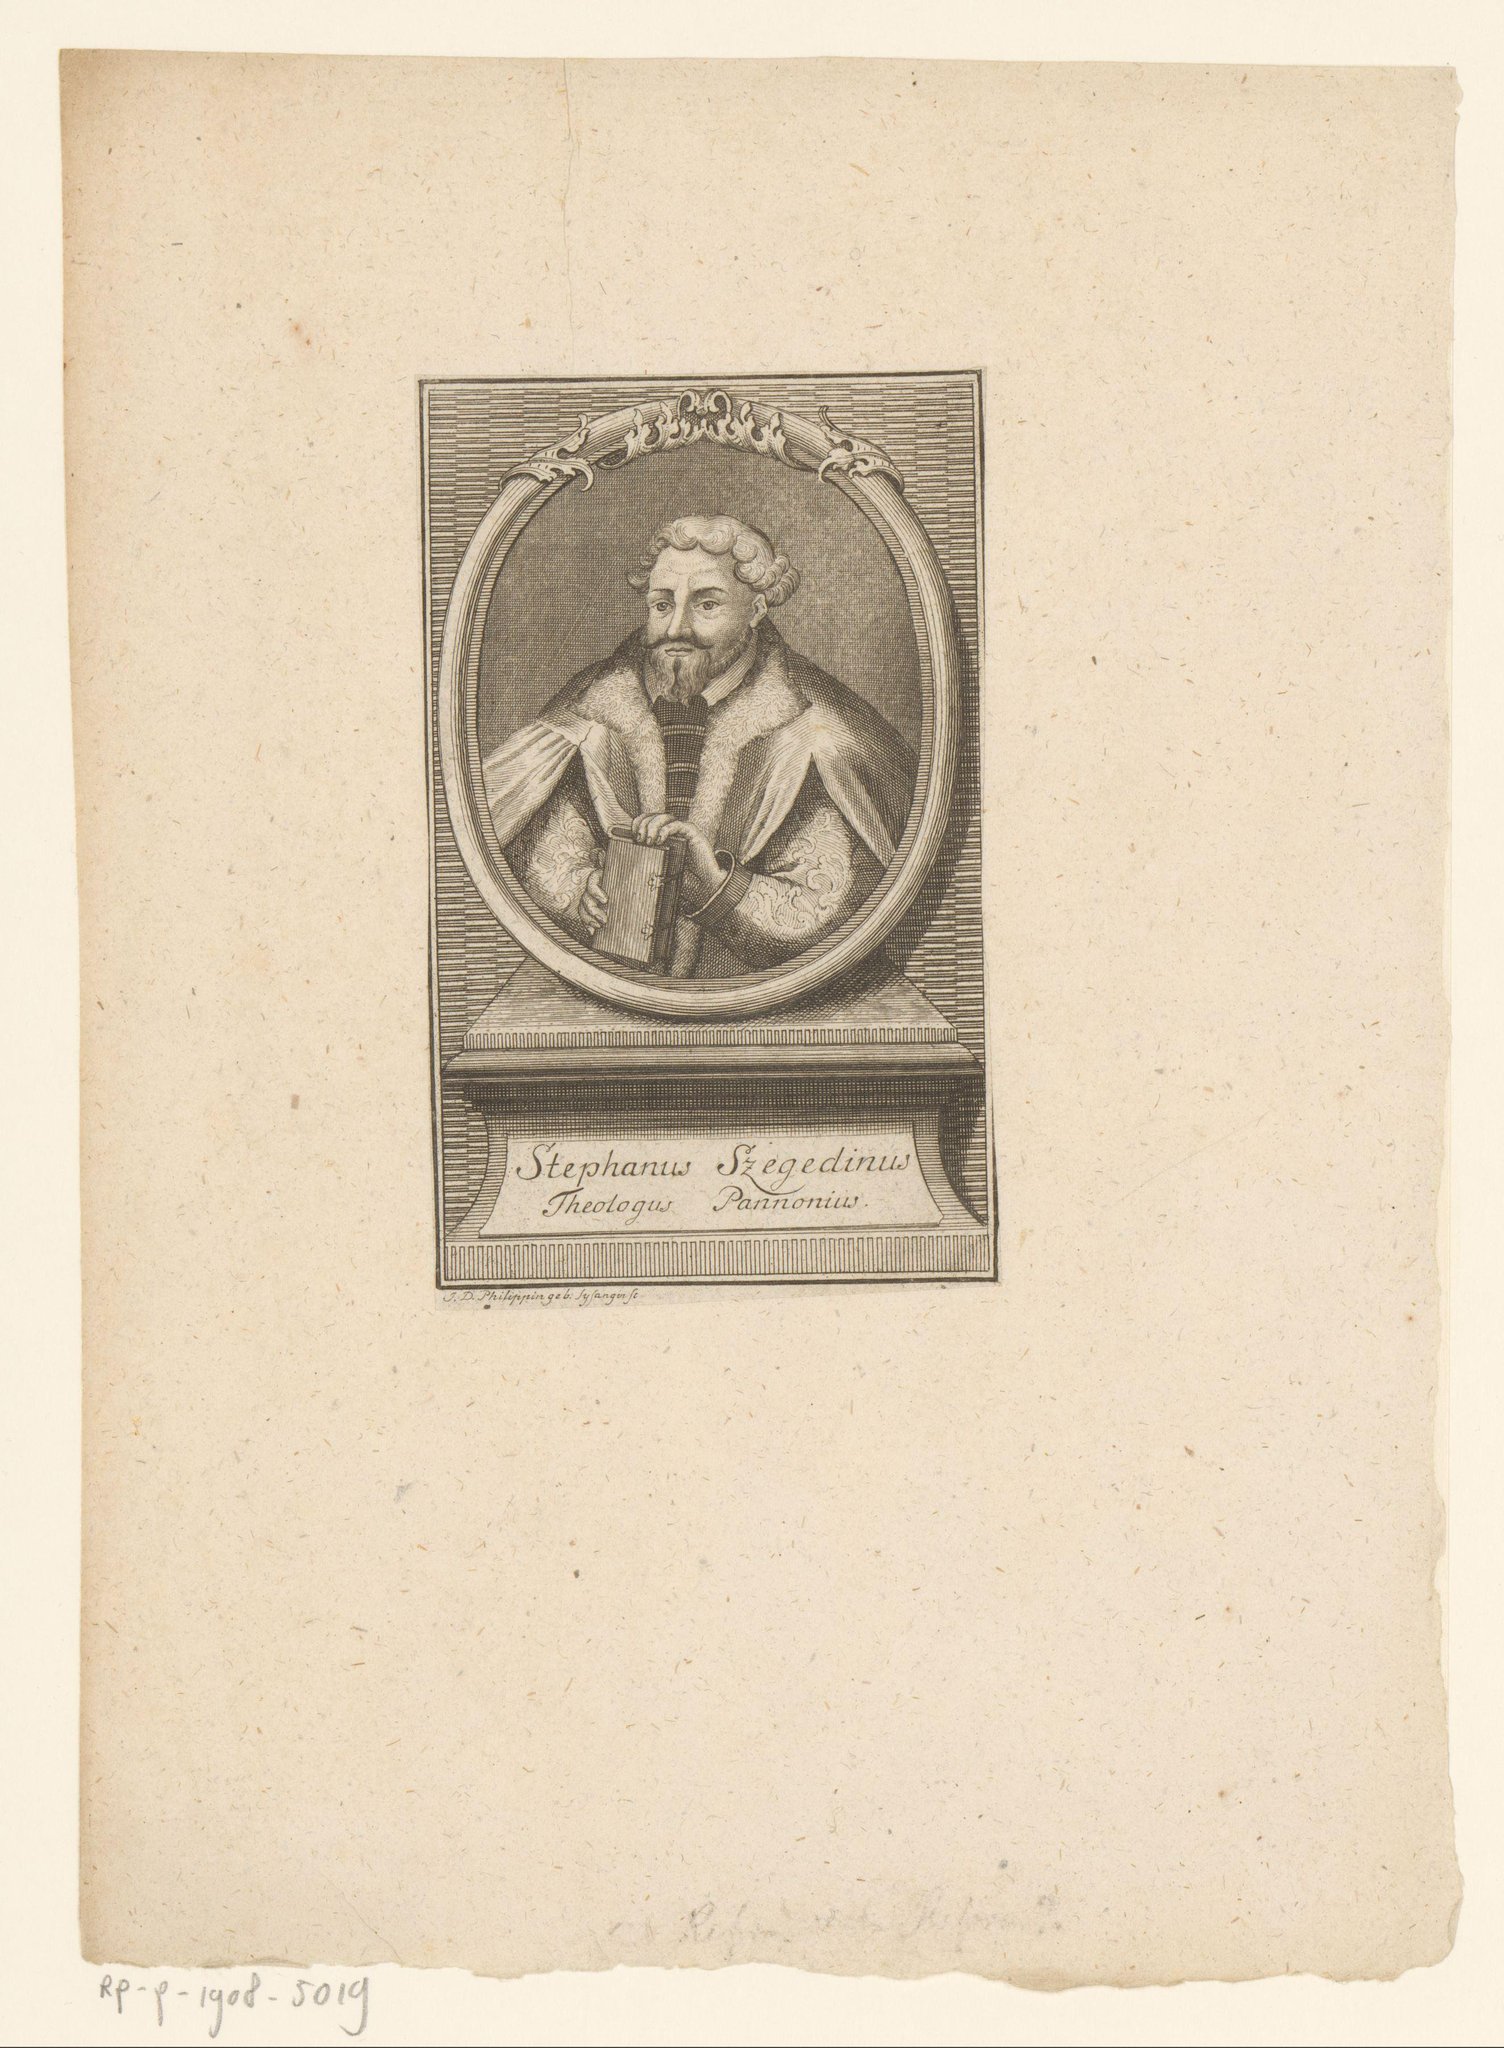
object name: print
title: Portret van Stephanus Szegedinus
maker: johanna dorothea sysang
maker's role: print maker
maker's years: 1729-1791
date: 1739-1791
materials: paper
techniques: engraving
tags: historical persons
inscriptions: collector's mark: Lugt 2228